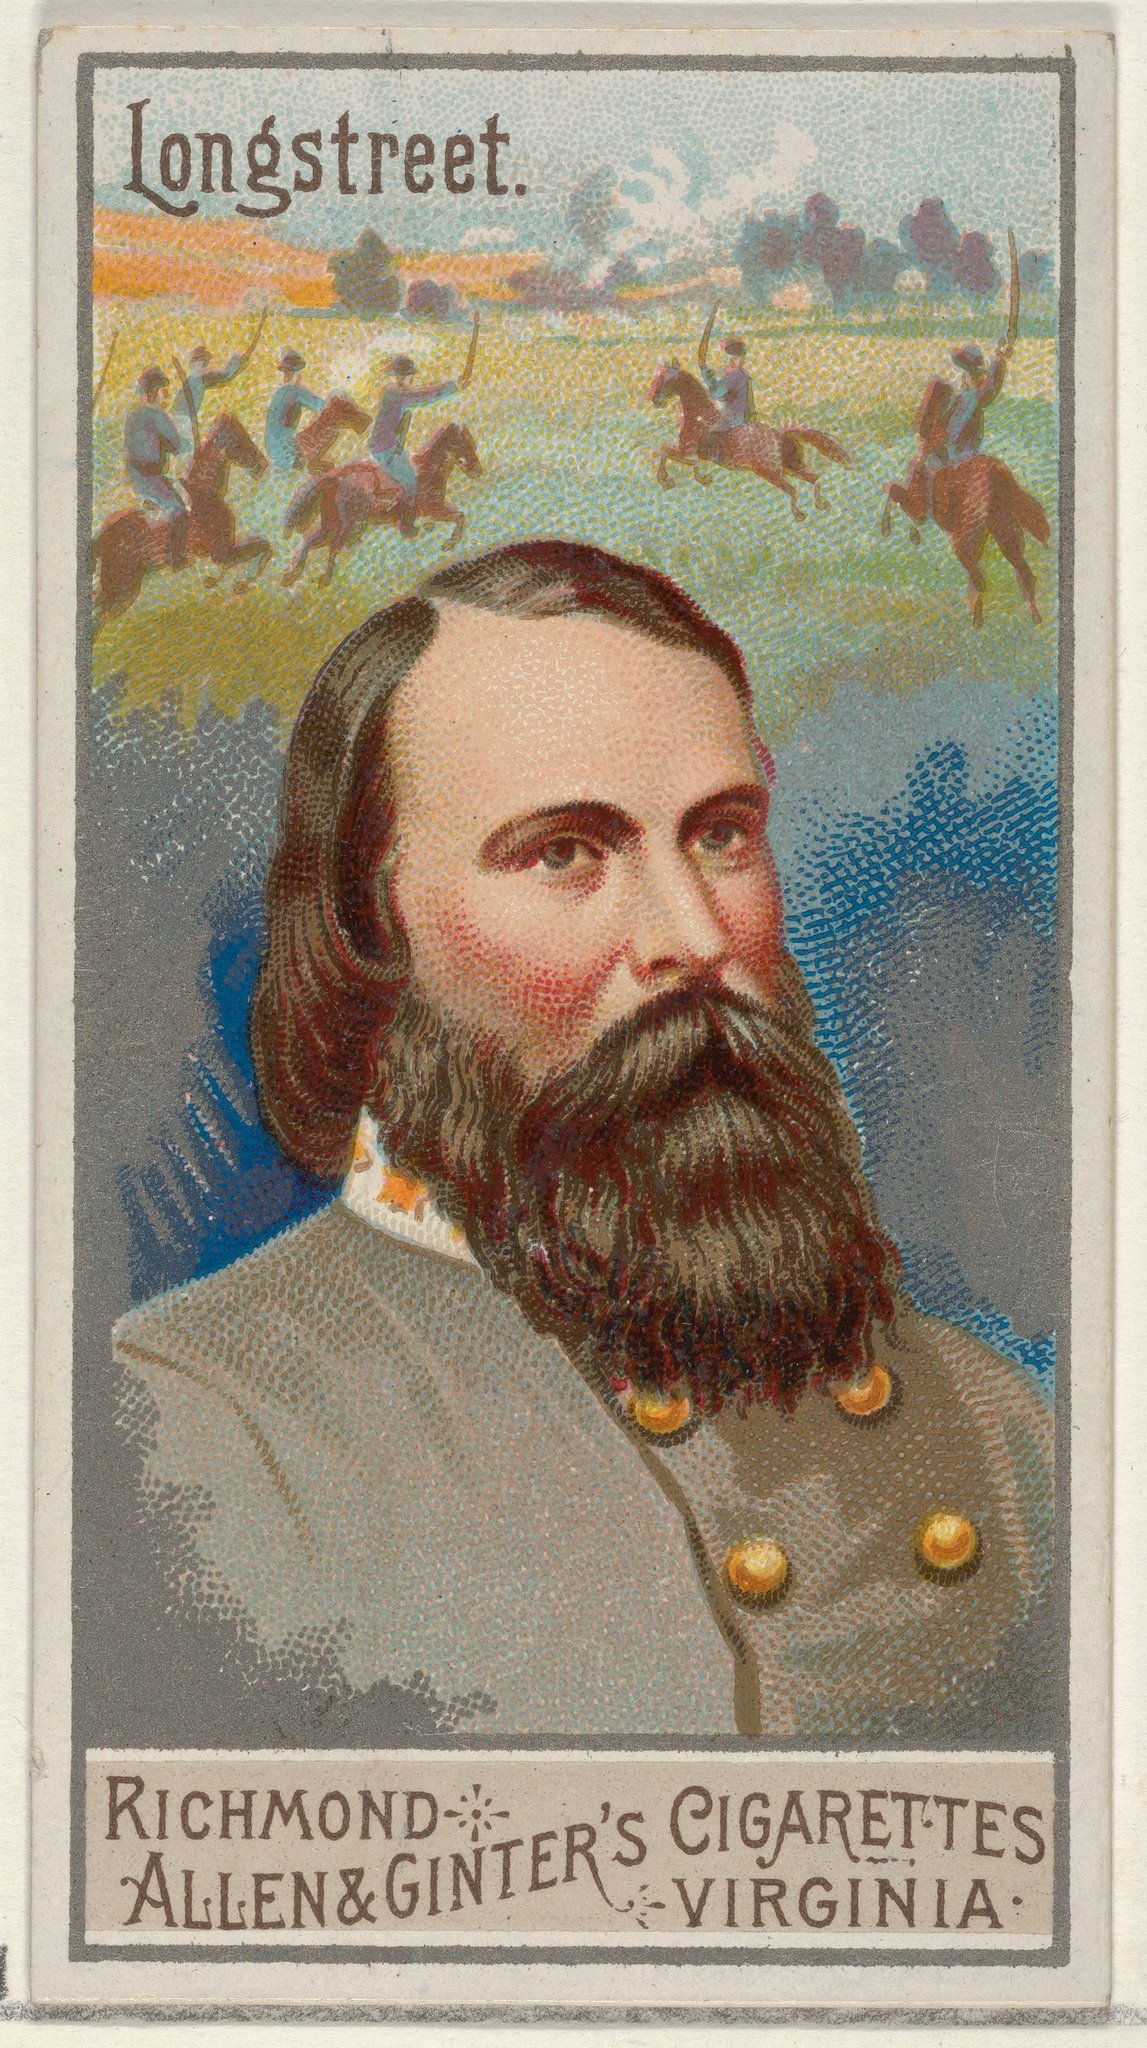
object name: print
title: James Longstreet, from the Great Generals series (N15) for Allen & Ginter Cigarettes Brands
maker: allen & ginter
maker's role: publisher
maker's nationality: american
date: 1888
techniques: color lithograph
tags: men,generals